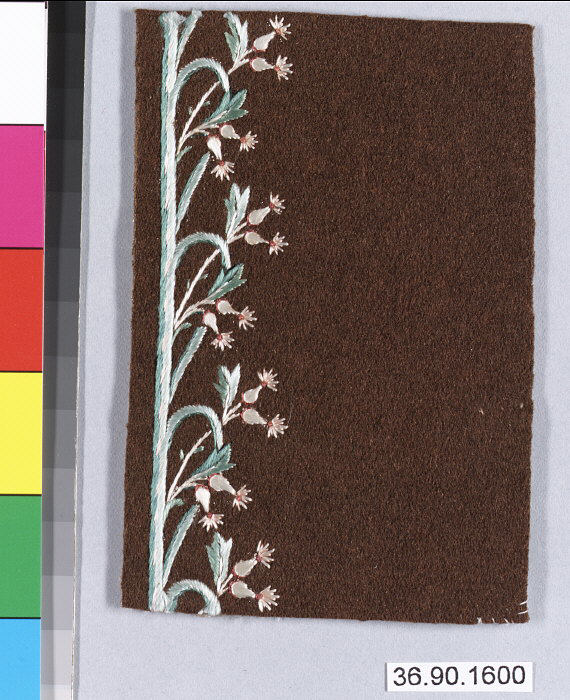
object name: sample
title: Embroidery sample for a man’s suit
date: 1785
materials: silk, wool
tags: flowers